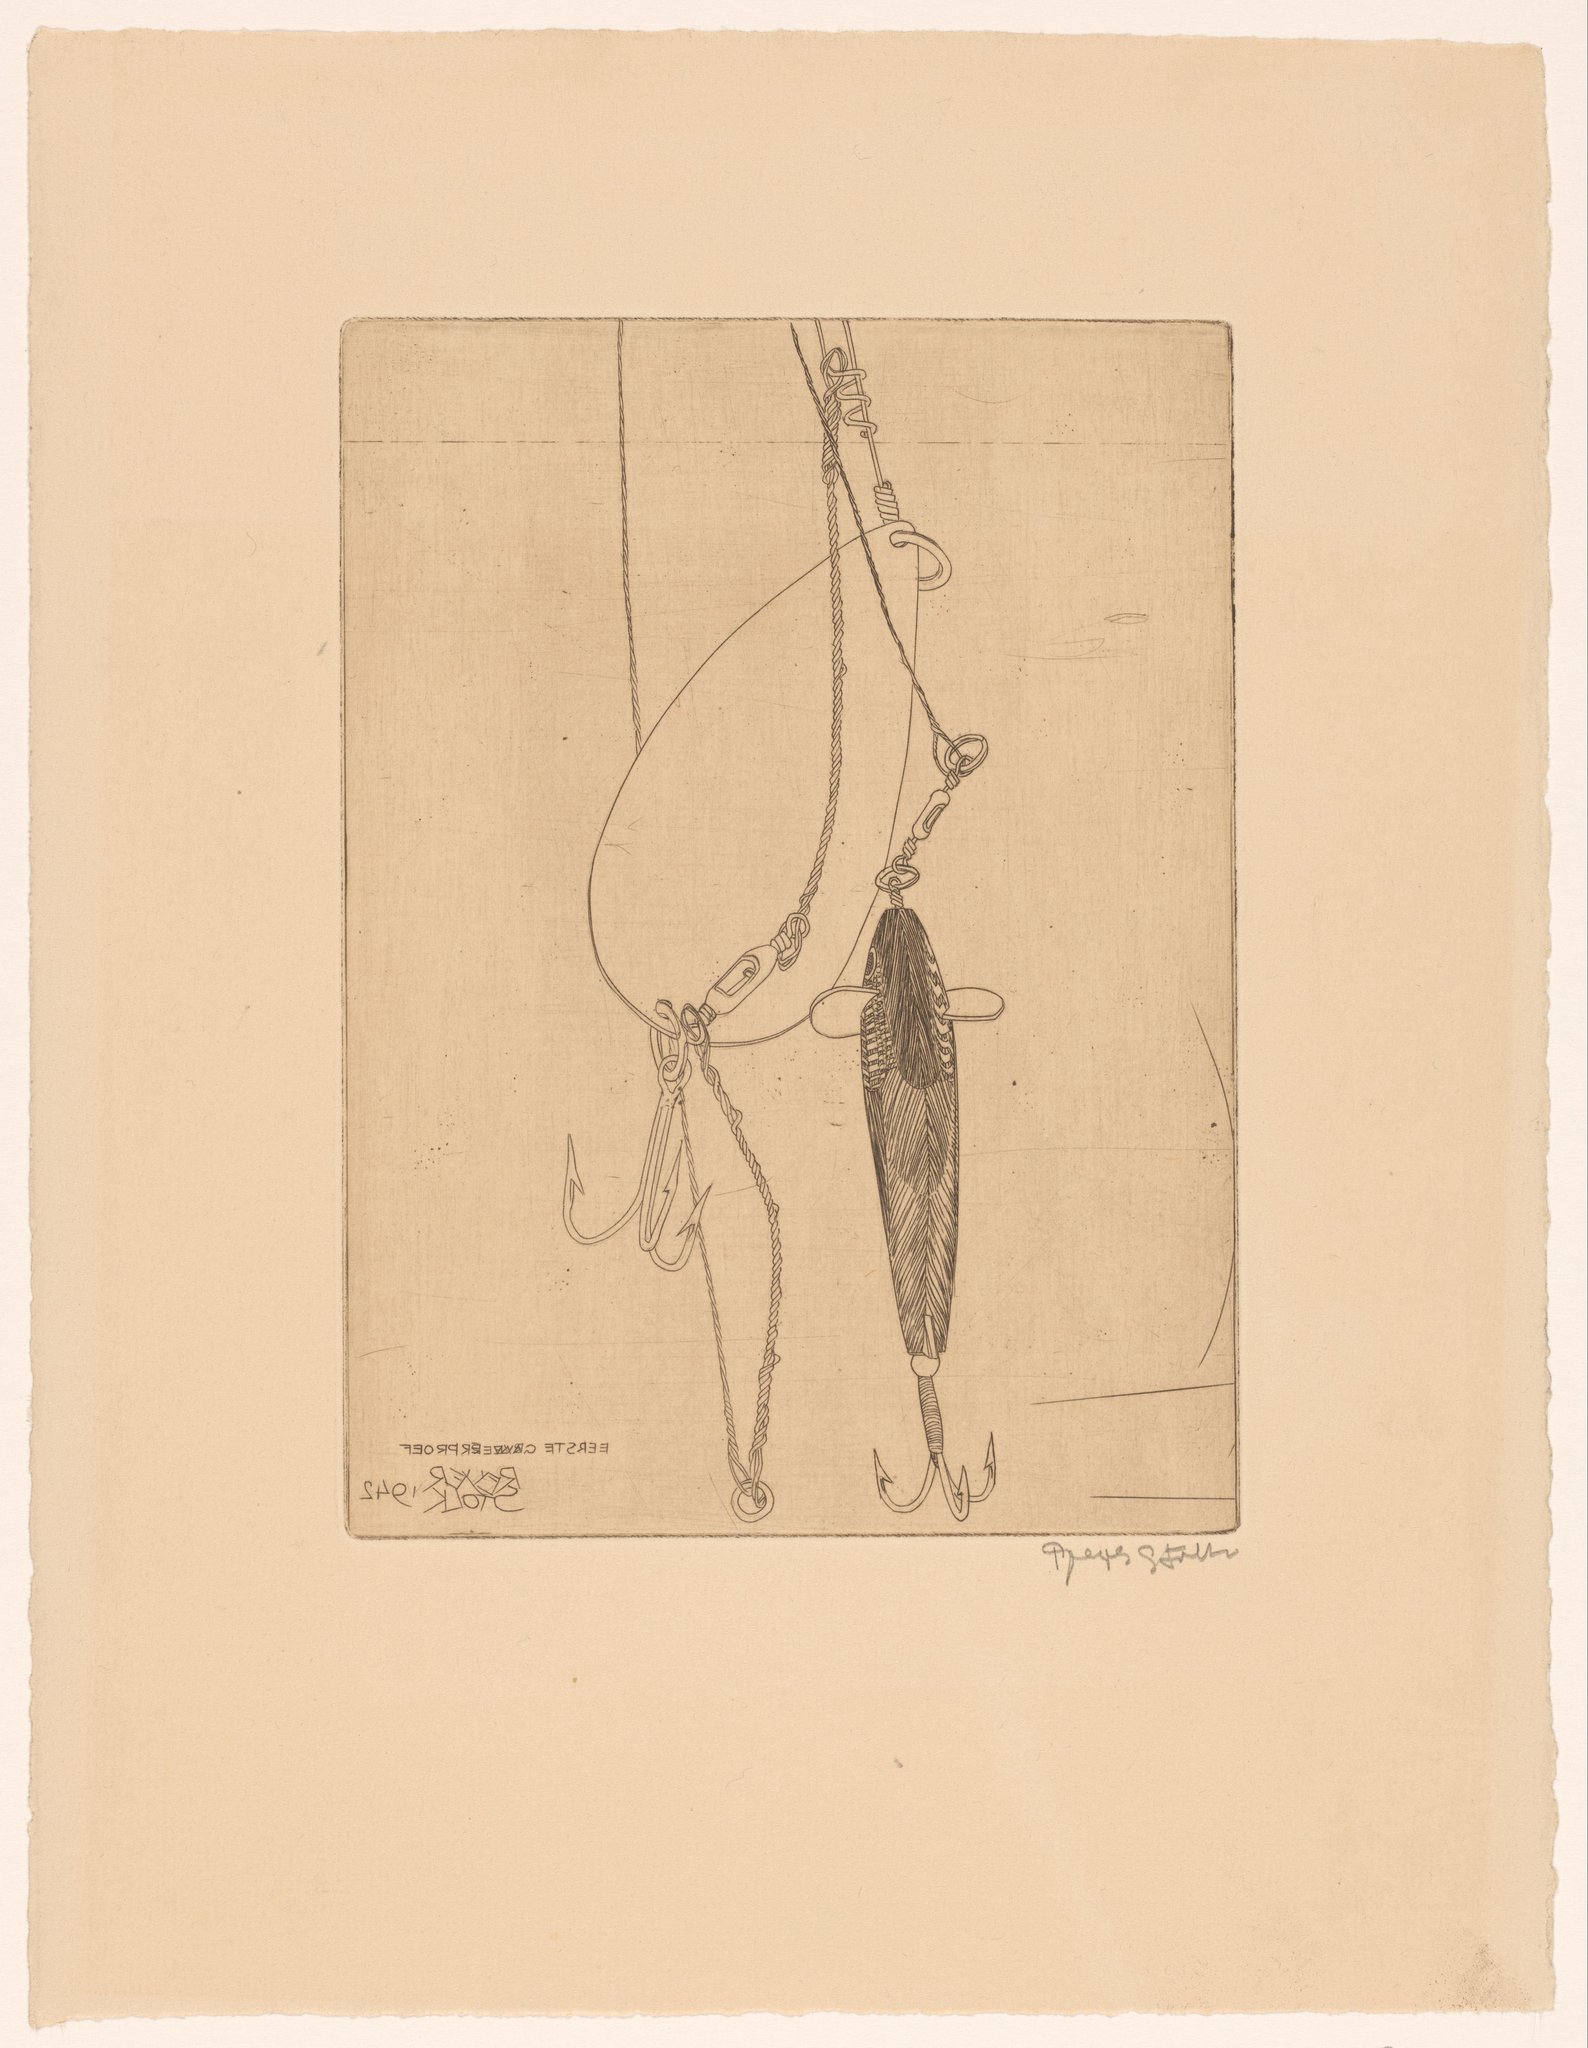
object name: print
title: Vishaken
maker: reijer stolk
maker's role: draughtsman, print maker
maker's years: 1896-1945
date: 1942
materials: paper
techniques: engraving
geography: netherlands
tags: fishing (sports) (+ fishing equipment)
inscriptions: collector's mark: Lugt 2228